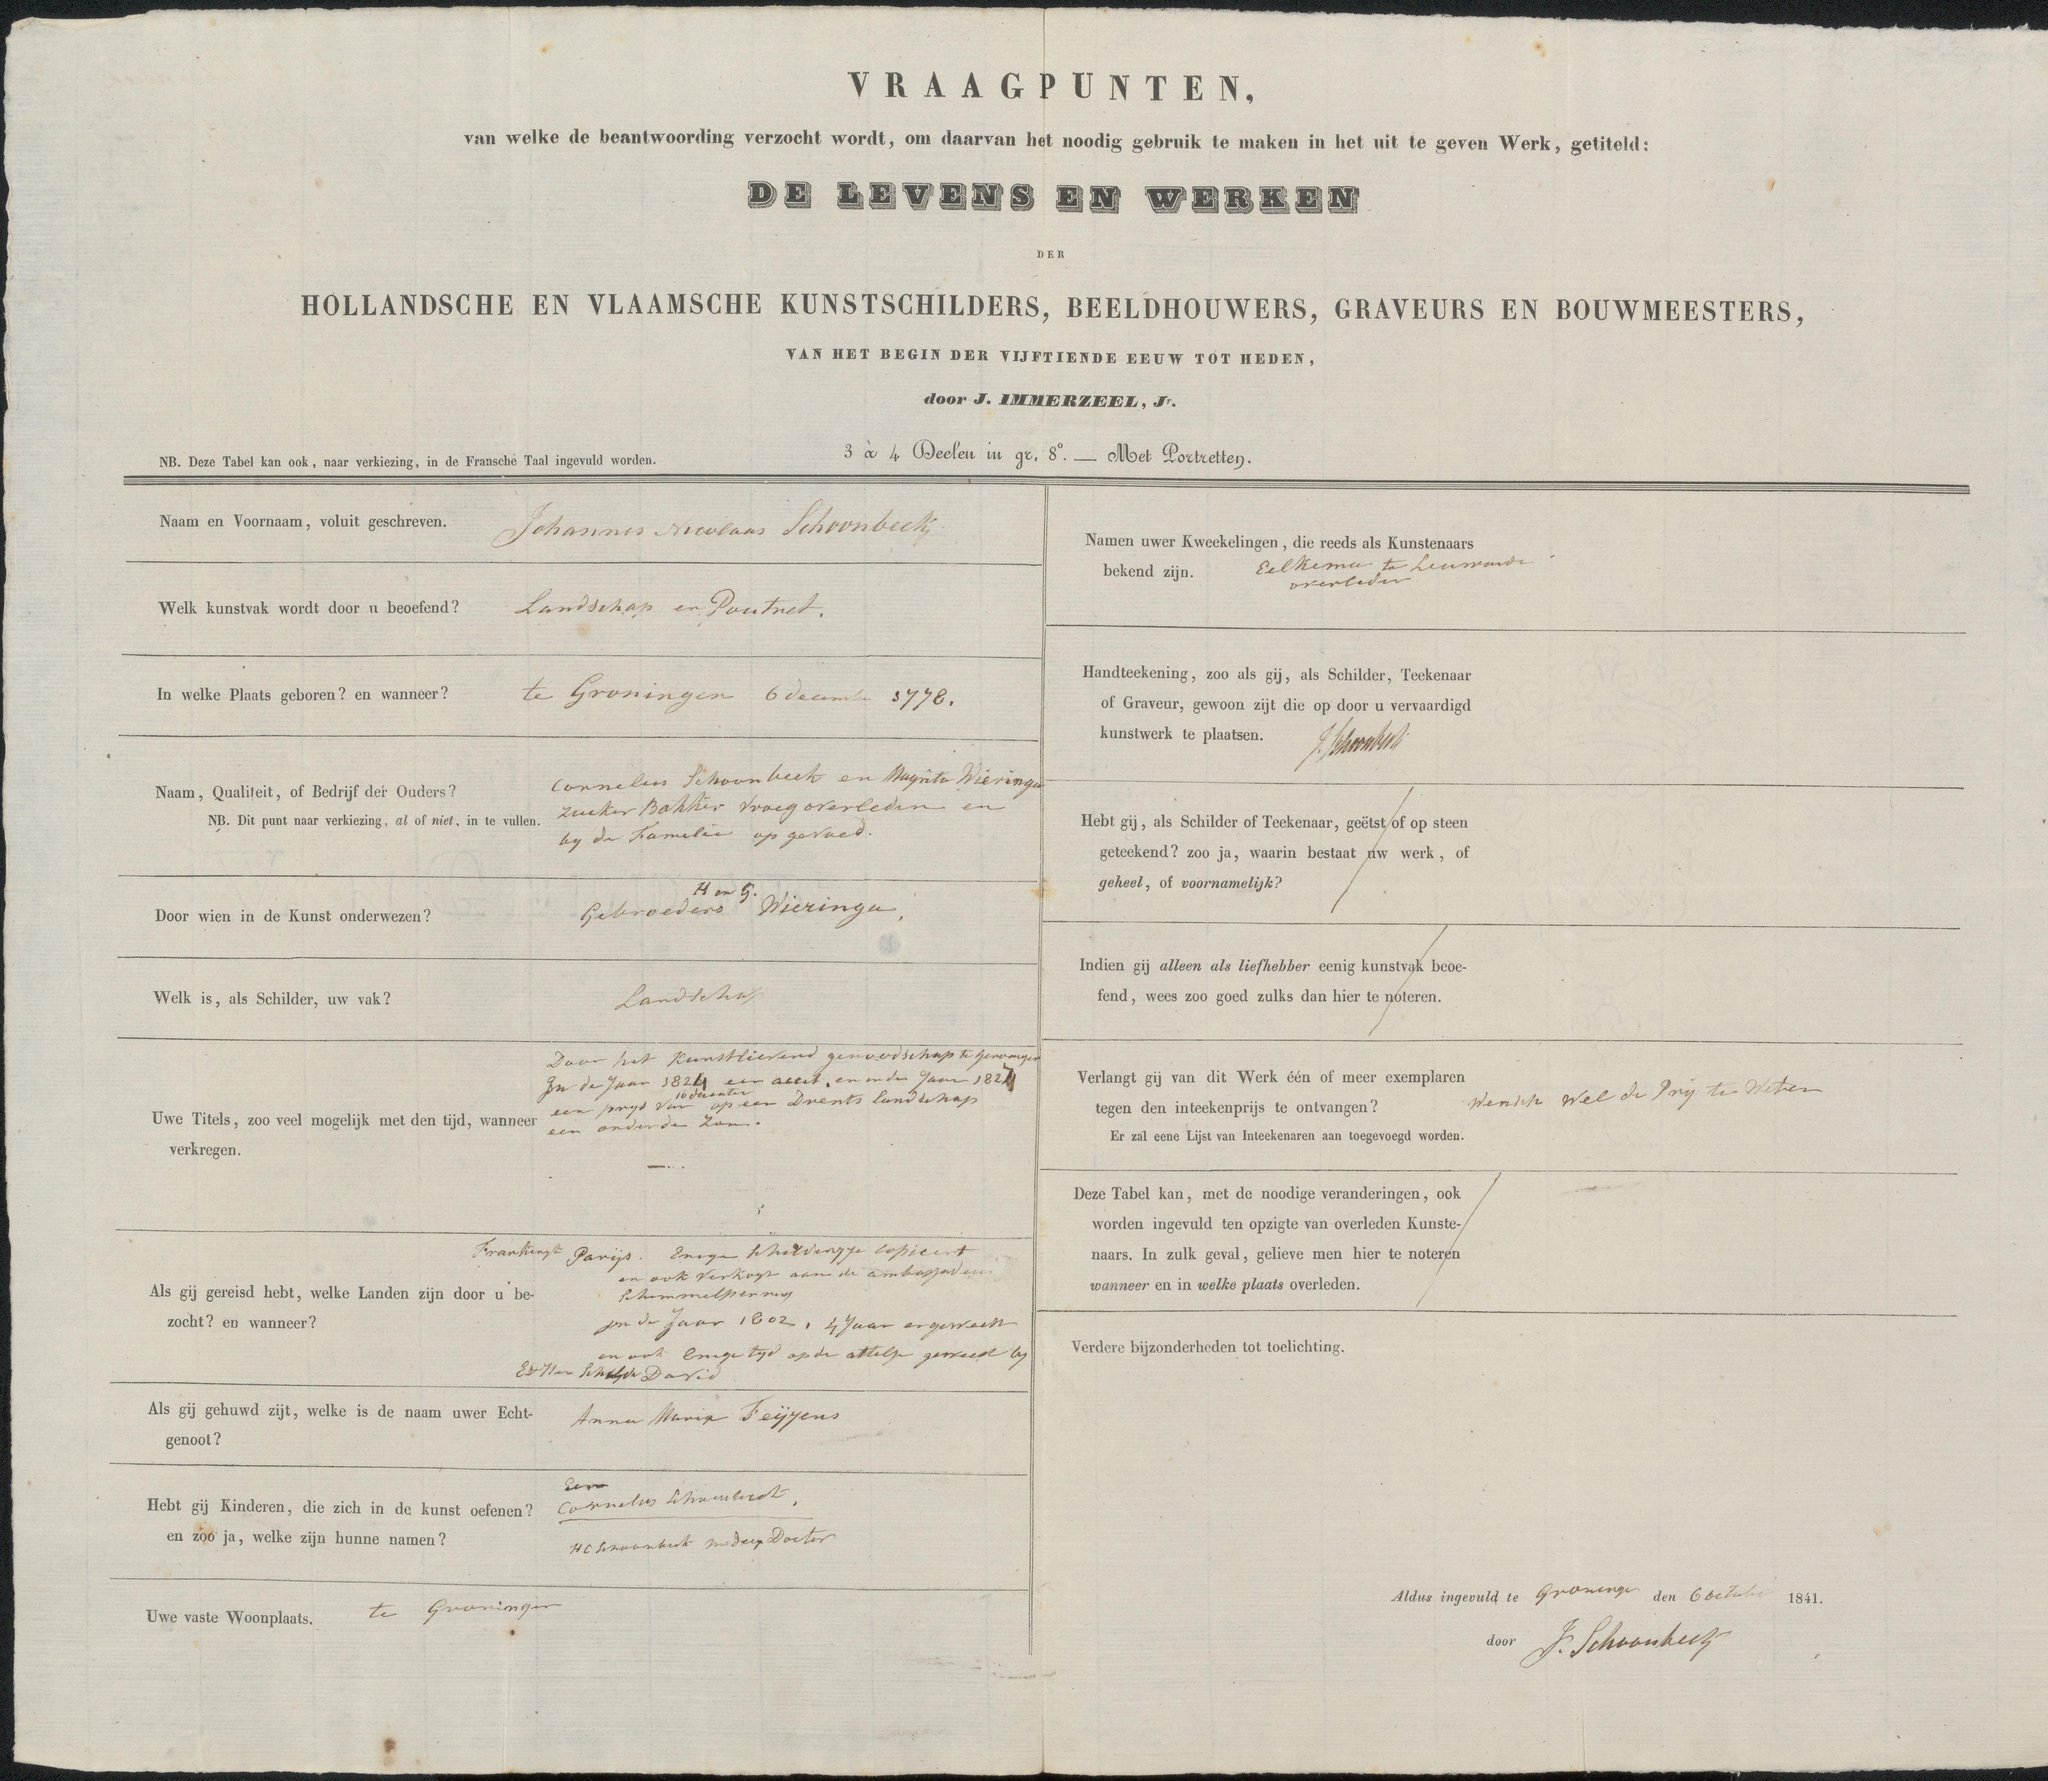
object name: questionnaire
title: Enquêteformulier ingevuld door Joannes Nicolaus Schoonbeek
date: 1841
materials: ink, paper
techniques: pen, printing, writing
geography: groningen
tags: painter, joannes nicolaus schoonbeek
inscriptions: watermark, inscription: ‘Vraagpunten,/ van welke de beantwoording verzocht wordt, om daarvan het noodig gebruik te maken in het uit te geven Werk, getiteld: De levens en werken/ der Hollandsche en Vlaamsche kunstschilders, beeldhouwers,/ graveurs en bouwmeesters, van het begin der vijftiende eeuw tot heden/ door J. Immerzeel, Jr.’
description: Opgenomen in: Immerzeel, J. Jr., De levens en werken der Hollandsche en Vlaamsche kunstschilders, beeldhouwers, graveurs en bouwmeesters, van het begin der vijftiende eeuw tot heden, Amsterdam: J.C. van Kesteren, 1842-1843.